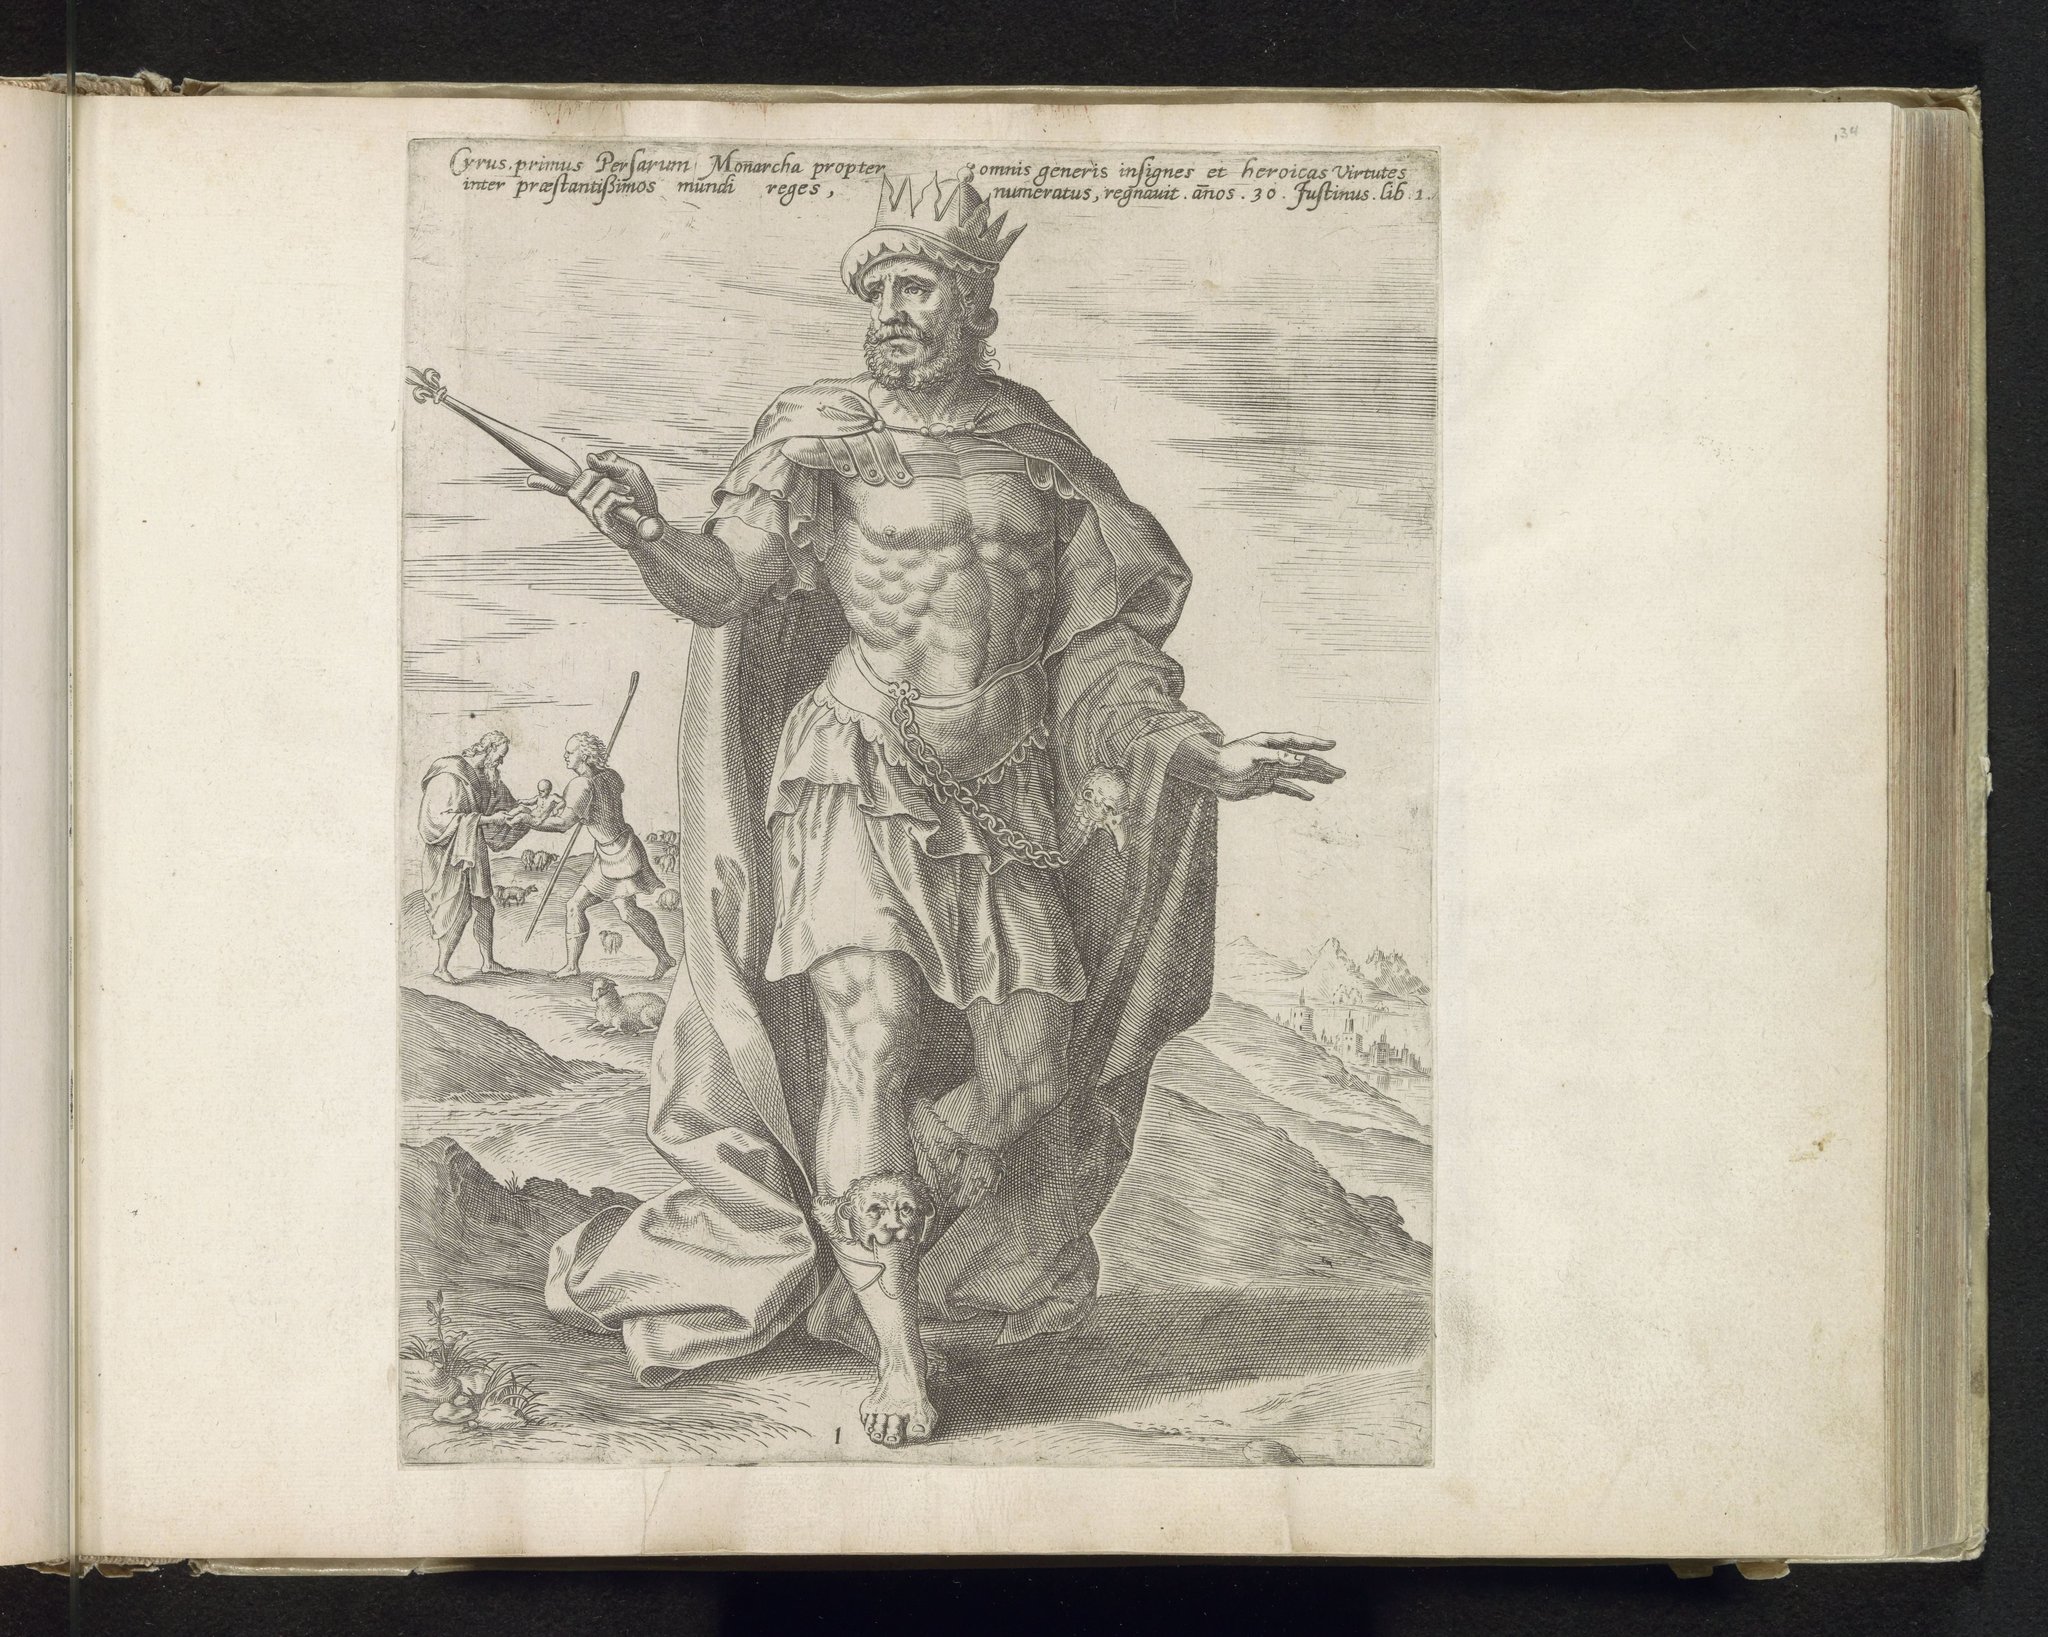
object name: print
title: Thesaurus sacrarum historiaru[m] veteris testame[n]ti, elega[n]tissimis imaginibus expressu[m] excelle[n]tissimoru[m] in hac arte viroru[m] opera: nu[n]c primu[m] in luce[m] editus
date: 1585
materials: paper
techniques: engraving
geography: antwerp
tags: instead of slaying cyrus, as ordered by king astyages, harpagus gives the baby to the shepherd mithridates to be exposed, (story of) cyrus king of persia - portrait of person from classical history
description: Koning Cyrus van Perzië staande met een scepter in zijn hand. Op de achtergrond is te zien hoe Cyrus als baby door Harpagus aan een herder wordt overhandigd. Boven de voorstelling een tweeregelige tekst in het Latijn. Deze prent maakt deel uit van een album.